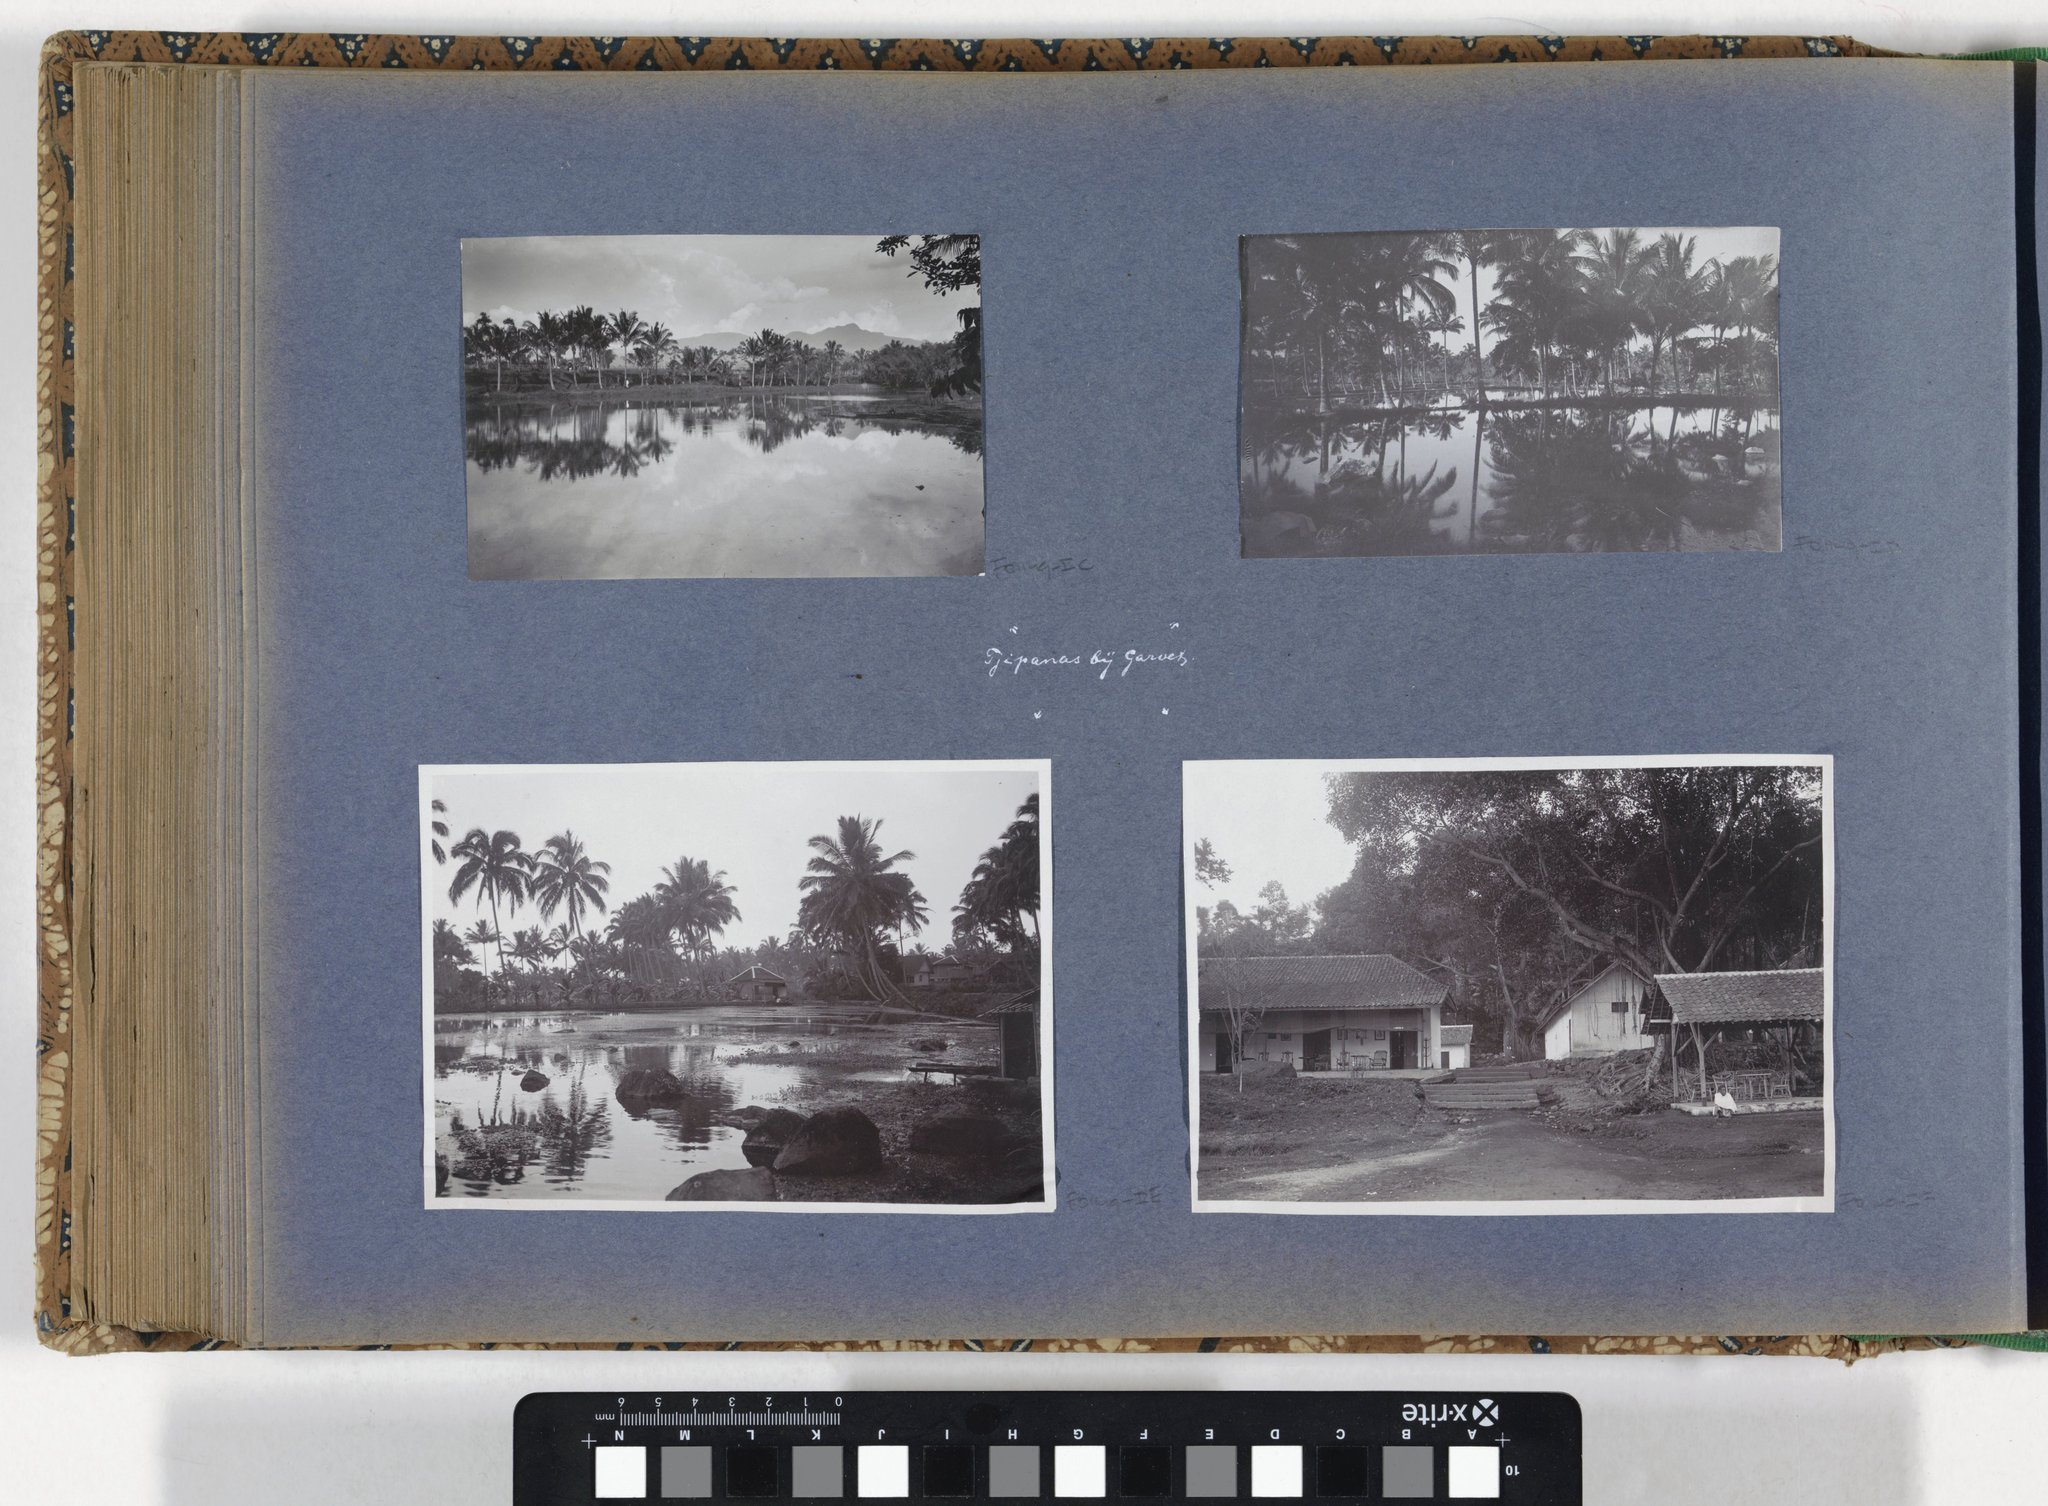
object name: album leaf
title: Meer met palmen bij Tjisoeroepan op Java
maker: Anonymous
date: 1900-1920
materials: paper, photographic support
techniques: gelatin silver print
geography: java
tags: lake, trees: palm-tree, java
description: Onderdeel van reisalbum met foto's van bedrijvigheid en bezienswaardigheden op Sumatra en Java en van de reis naar en van Nederlands-Indië.